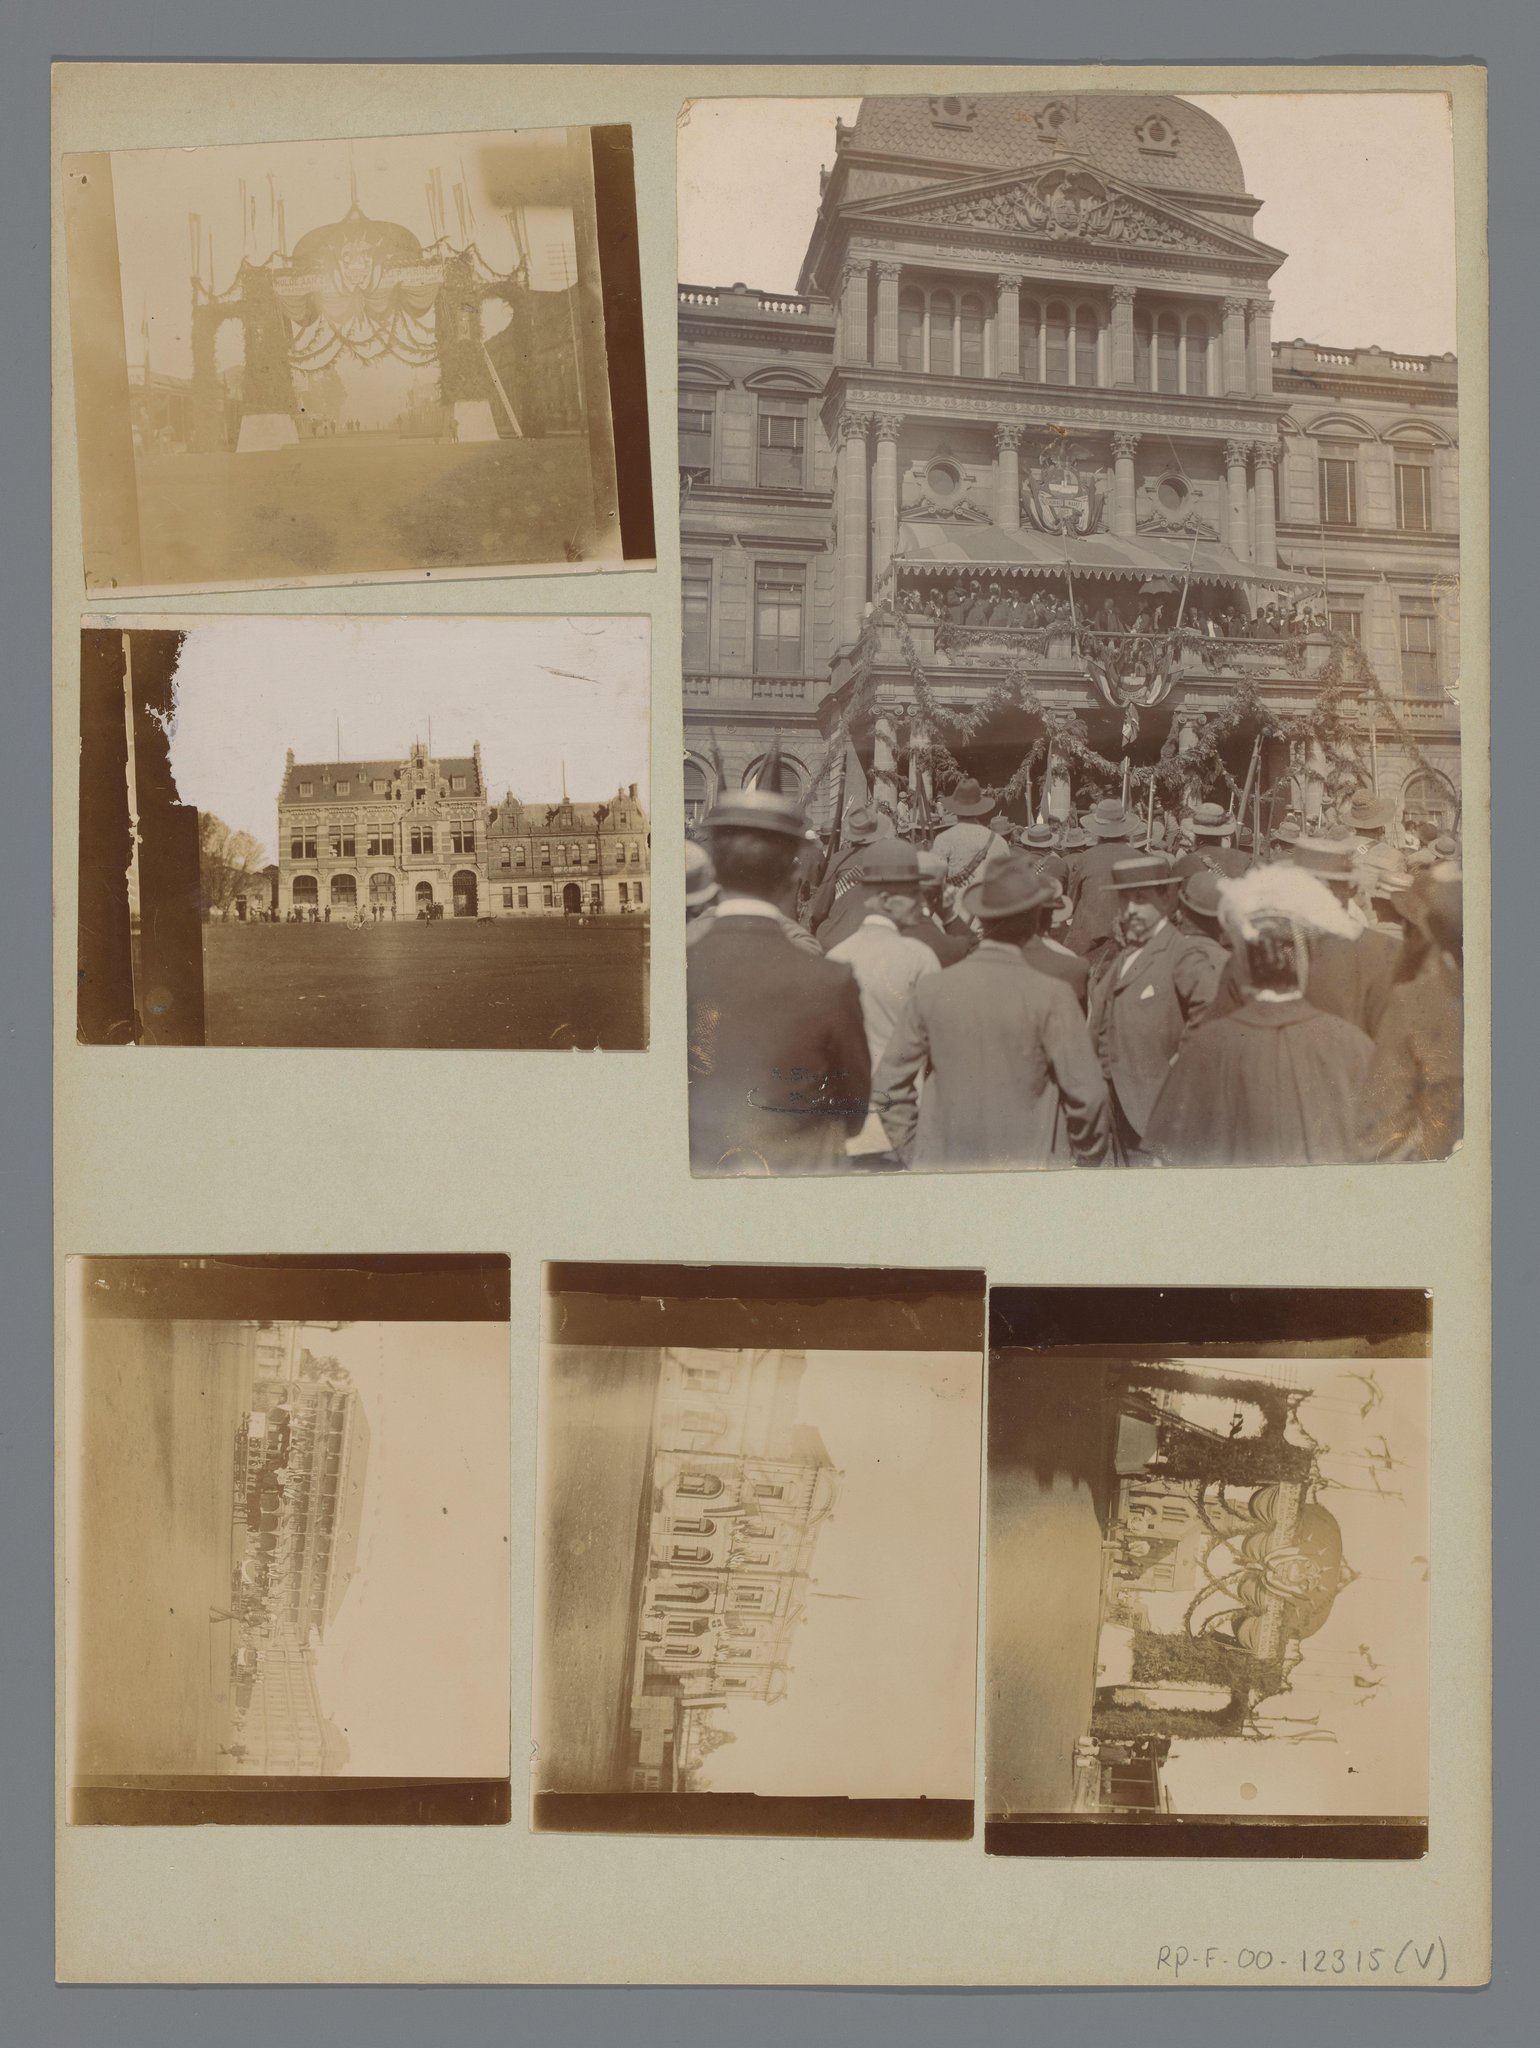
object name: blad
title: Blad met zes foto's van de inhuldiging van president Kruger in Pretoria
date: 1898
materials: paper, cardboard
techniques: gelatin silver print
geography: pretoria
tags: ceremonial celebration of installation of a ruler